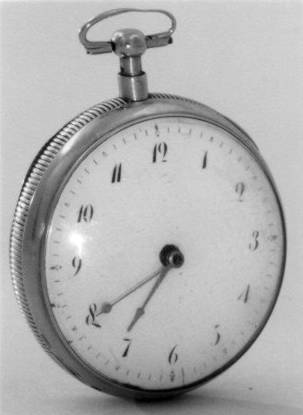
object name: music box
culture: swiss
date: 1820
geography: switzerland